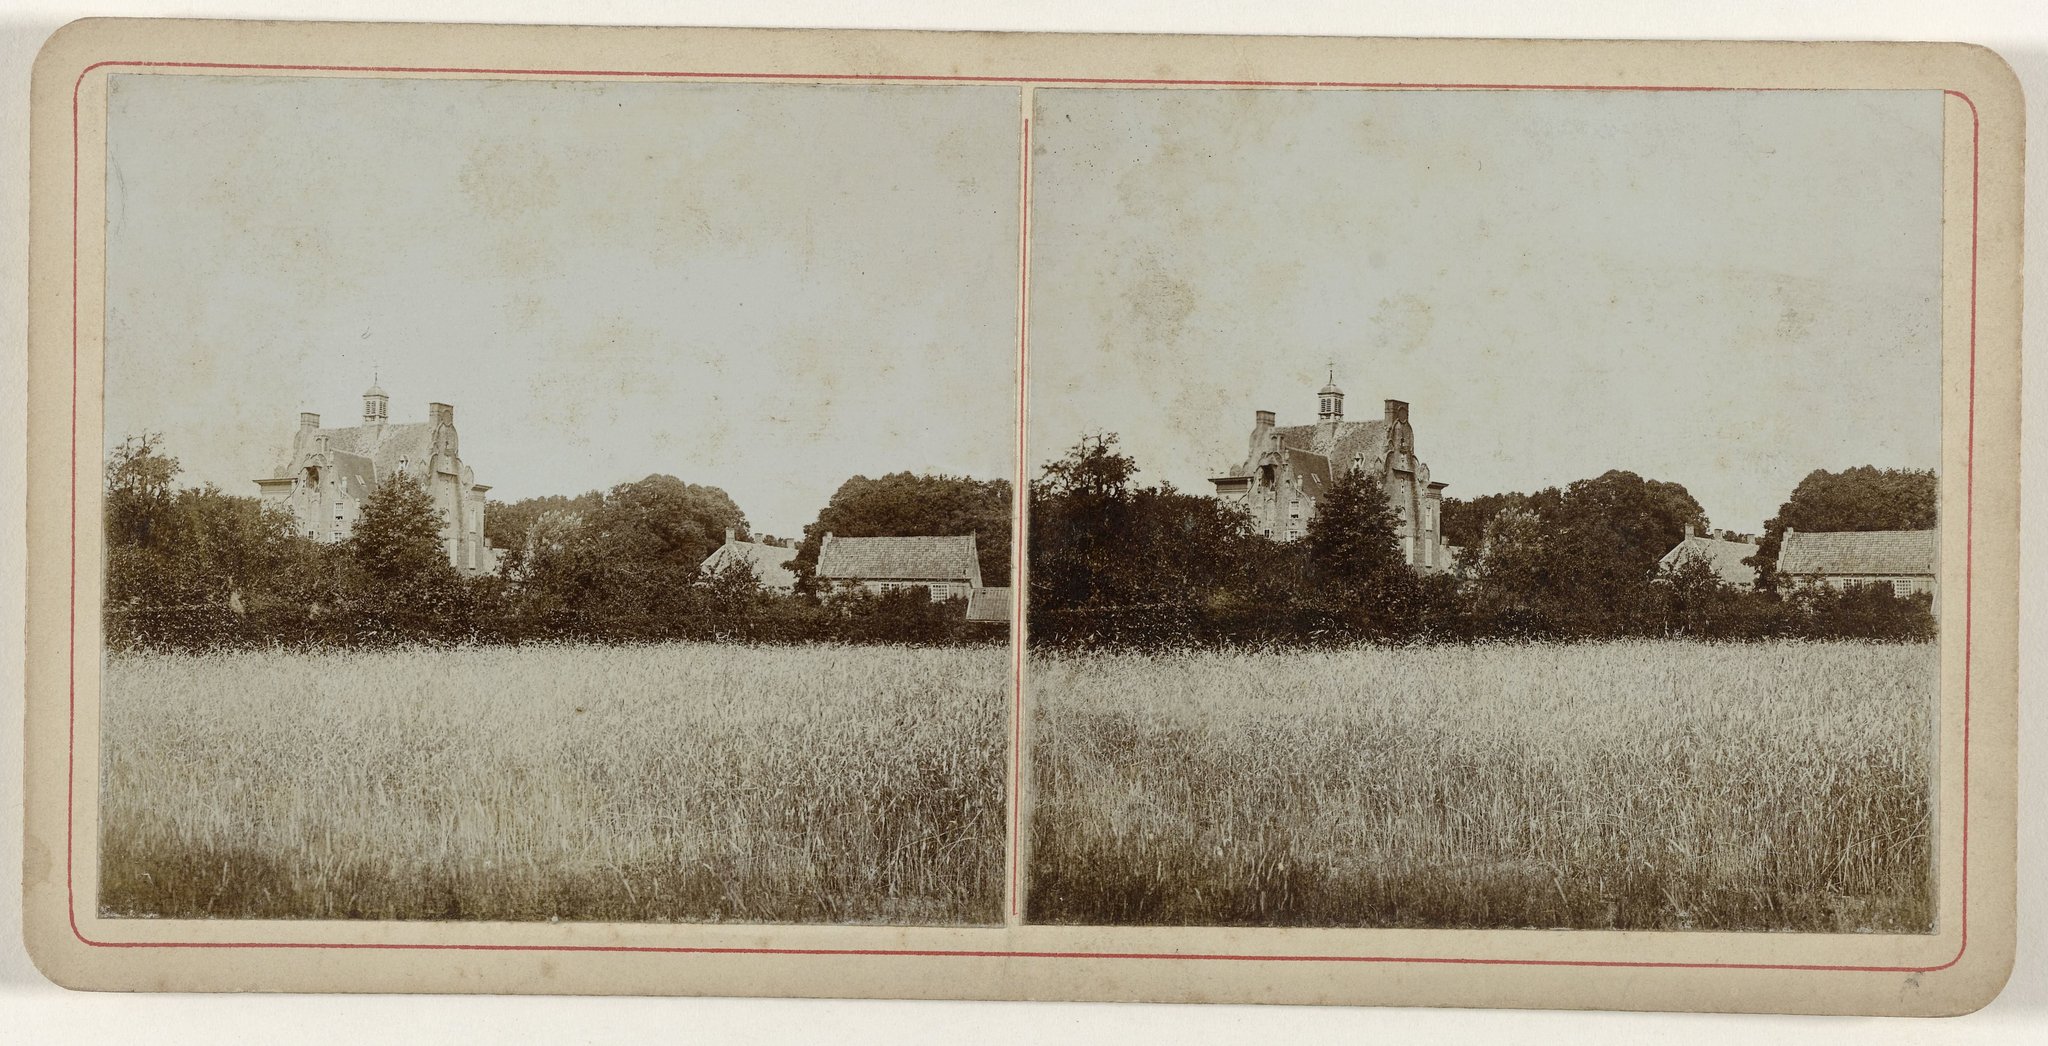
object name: stereograph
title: Huis ter Horst met bijgebouwen gezien vanaf de zijkant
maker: geldolph adriaan kessler (dolph)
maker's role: fotograaf, industrieel, voetballer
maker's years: 1884-1945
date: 1904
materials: paper, photographic support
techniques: collodion silver print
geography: gelderland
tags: netherlands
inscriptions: title: ‘Huis Ter Horst Aug; 1904’